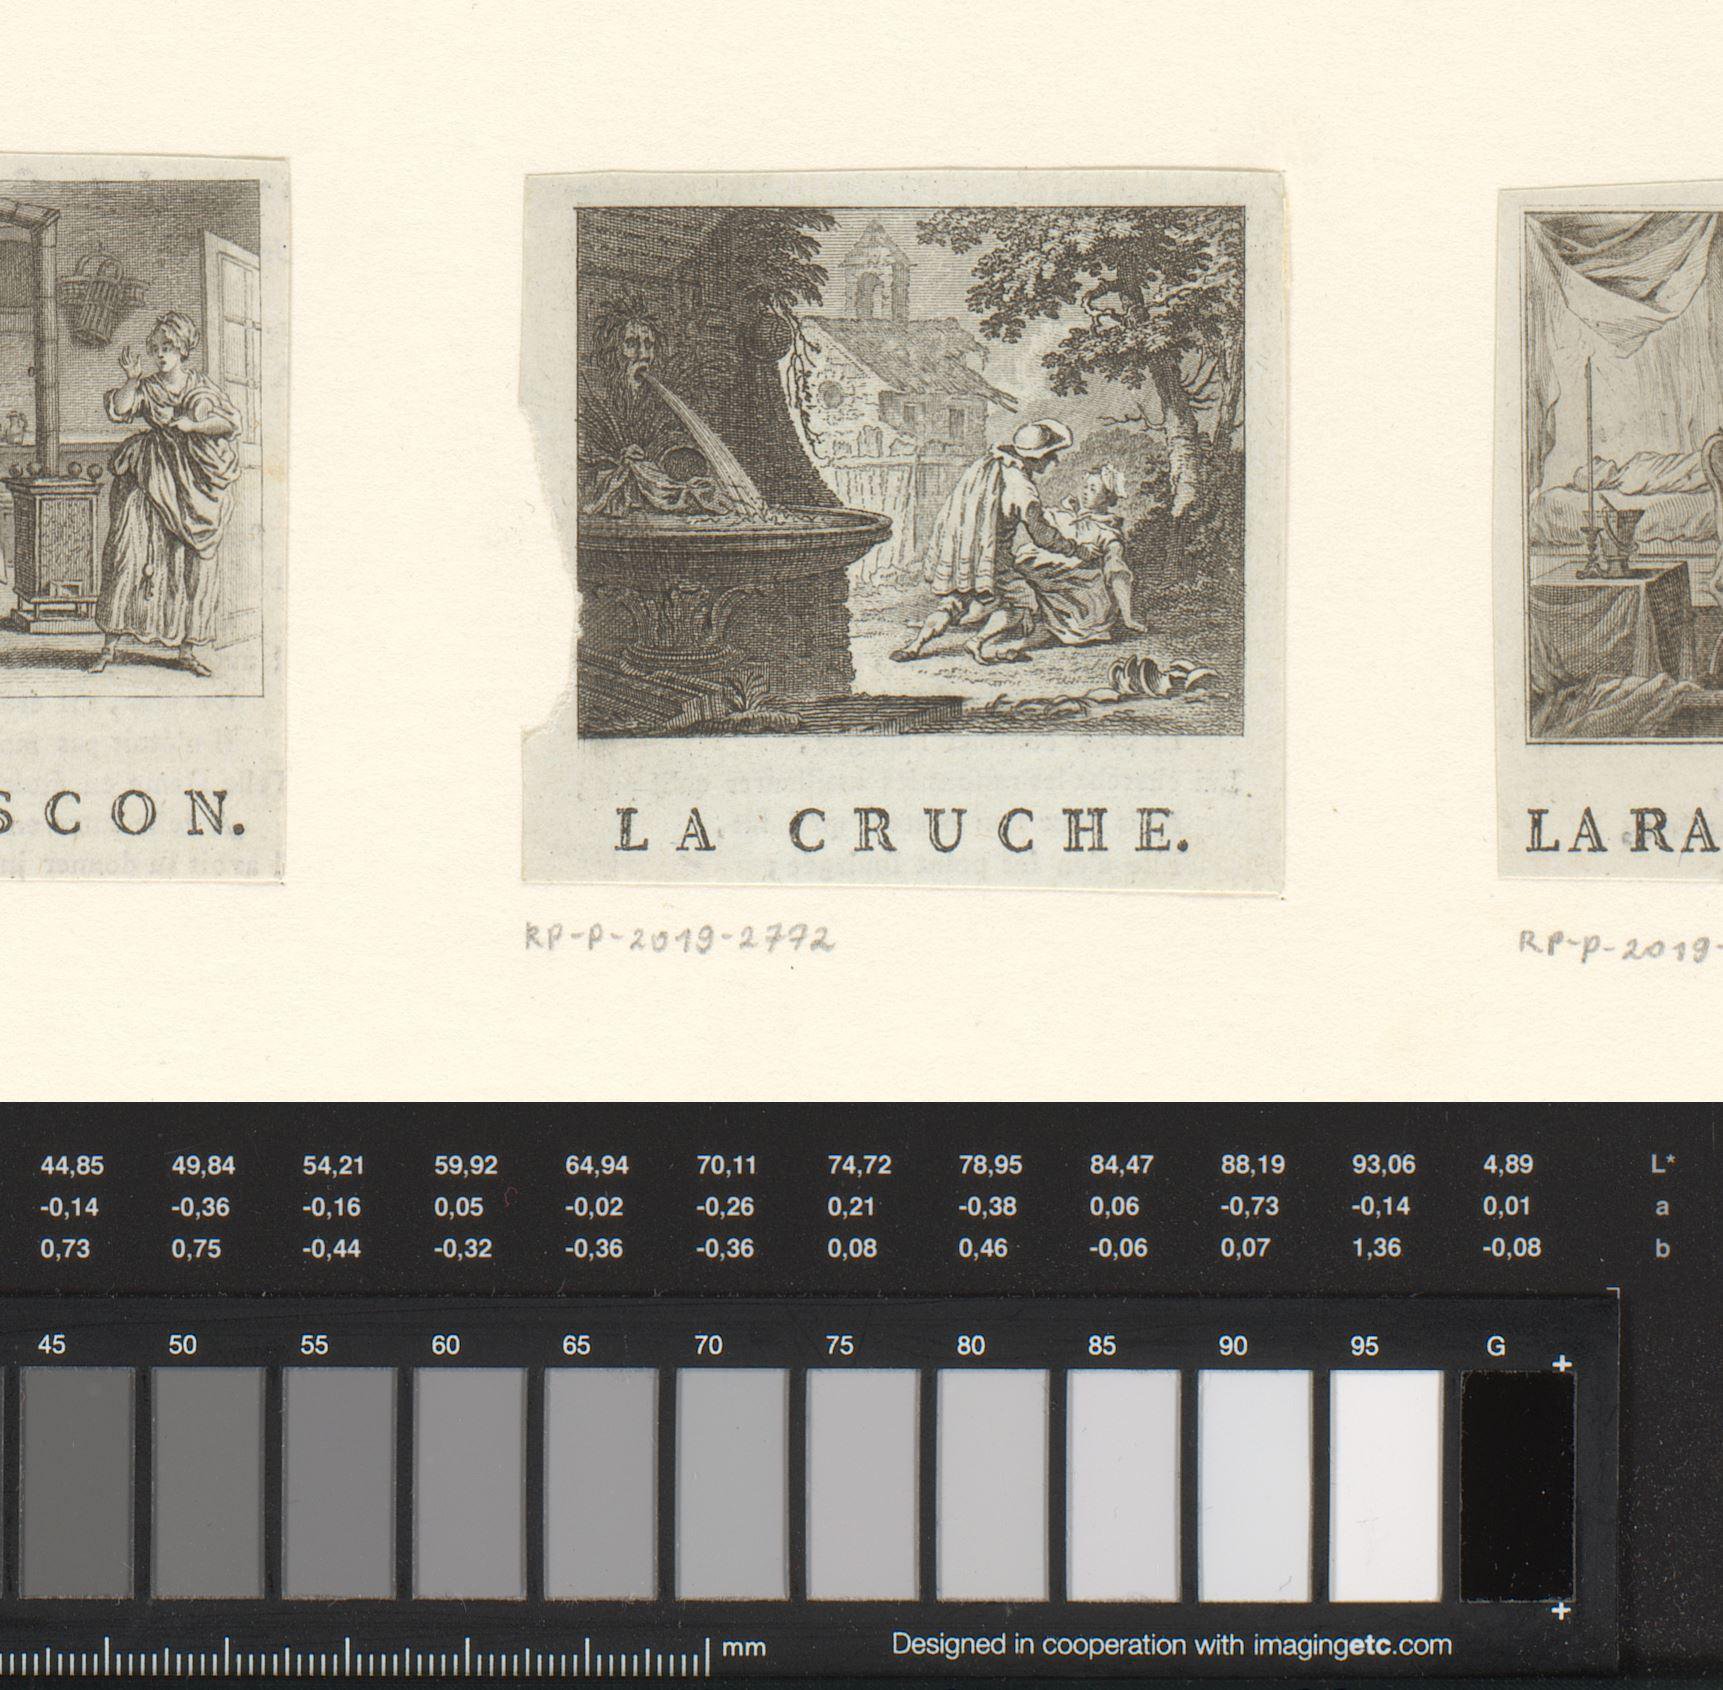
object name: print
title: Man en vrouw bij een waterspuwer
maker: Anonymous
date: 1763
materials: paper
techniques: engraving, etching, letterpress printing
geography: france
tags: ornamental fountain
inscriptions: collector's mark: Lugt 2228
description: Mogelijk prent uit: Grecourt, Jean Baptiste Joseph Willart de. Oeuvres diverses de M. de Grécourt, nouvelle édition, augmentée d'un grand nombre de pièces, revus sur les originales et du Philotanis. Amsterdam: s.n., 1763.